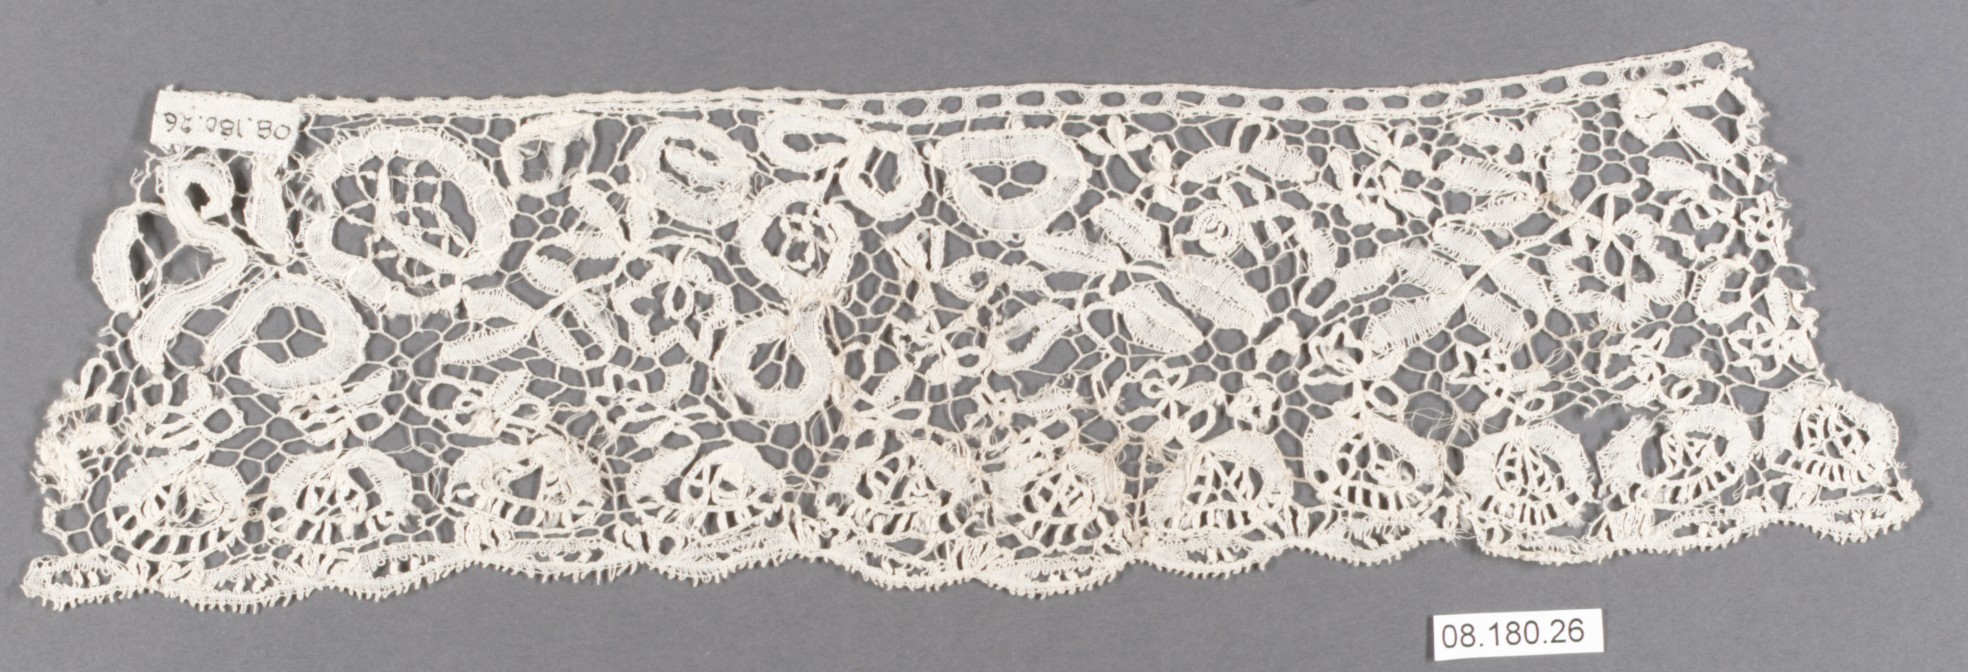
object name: fragment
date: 1801-1900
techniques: lace